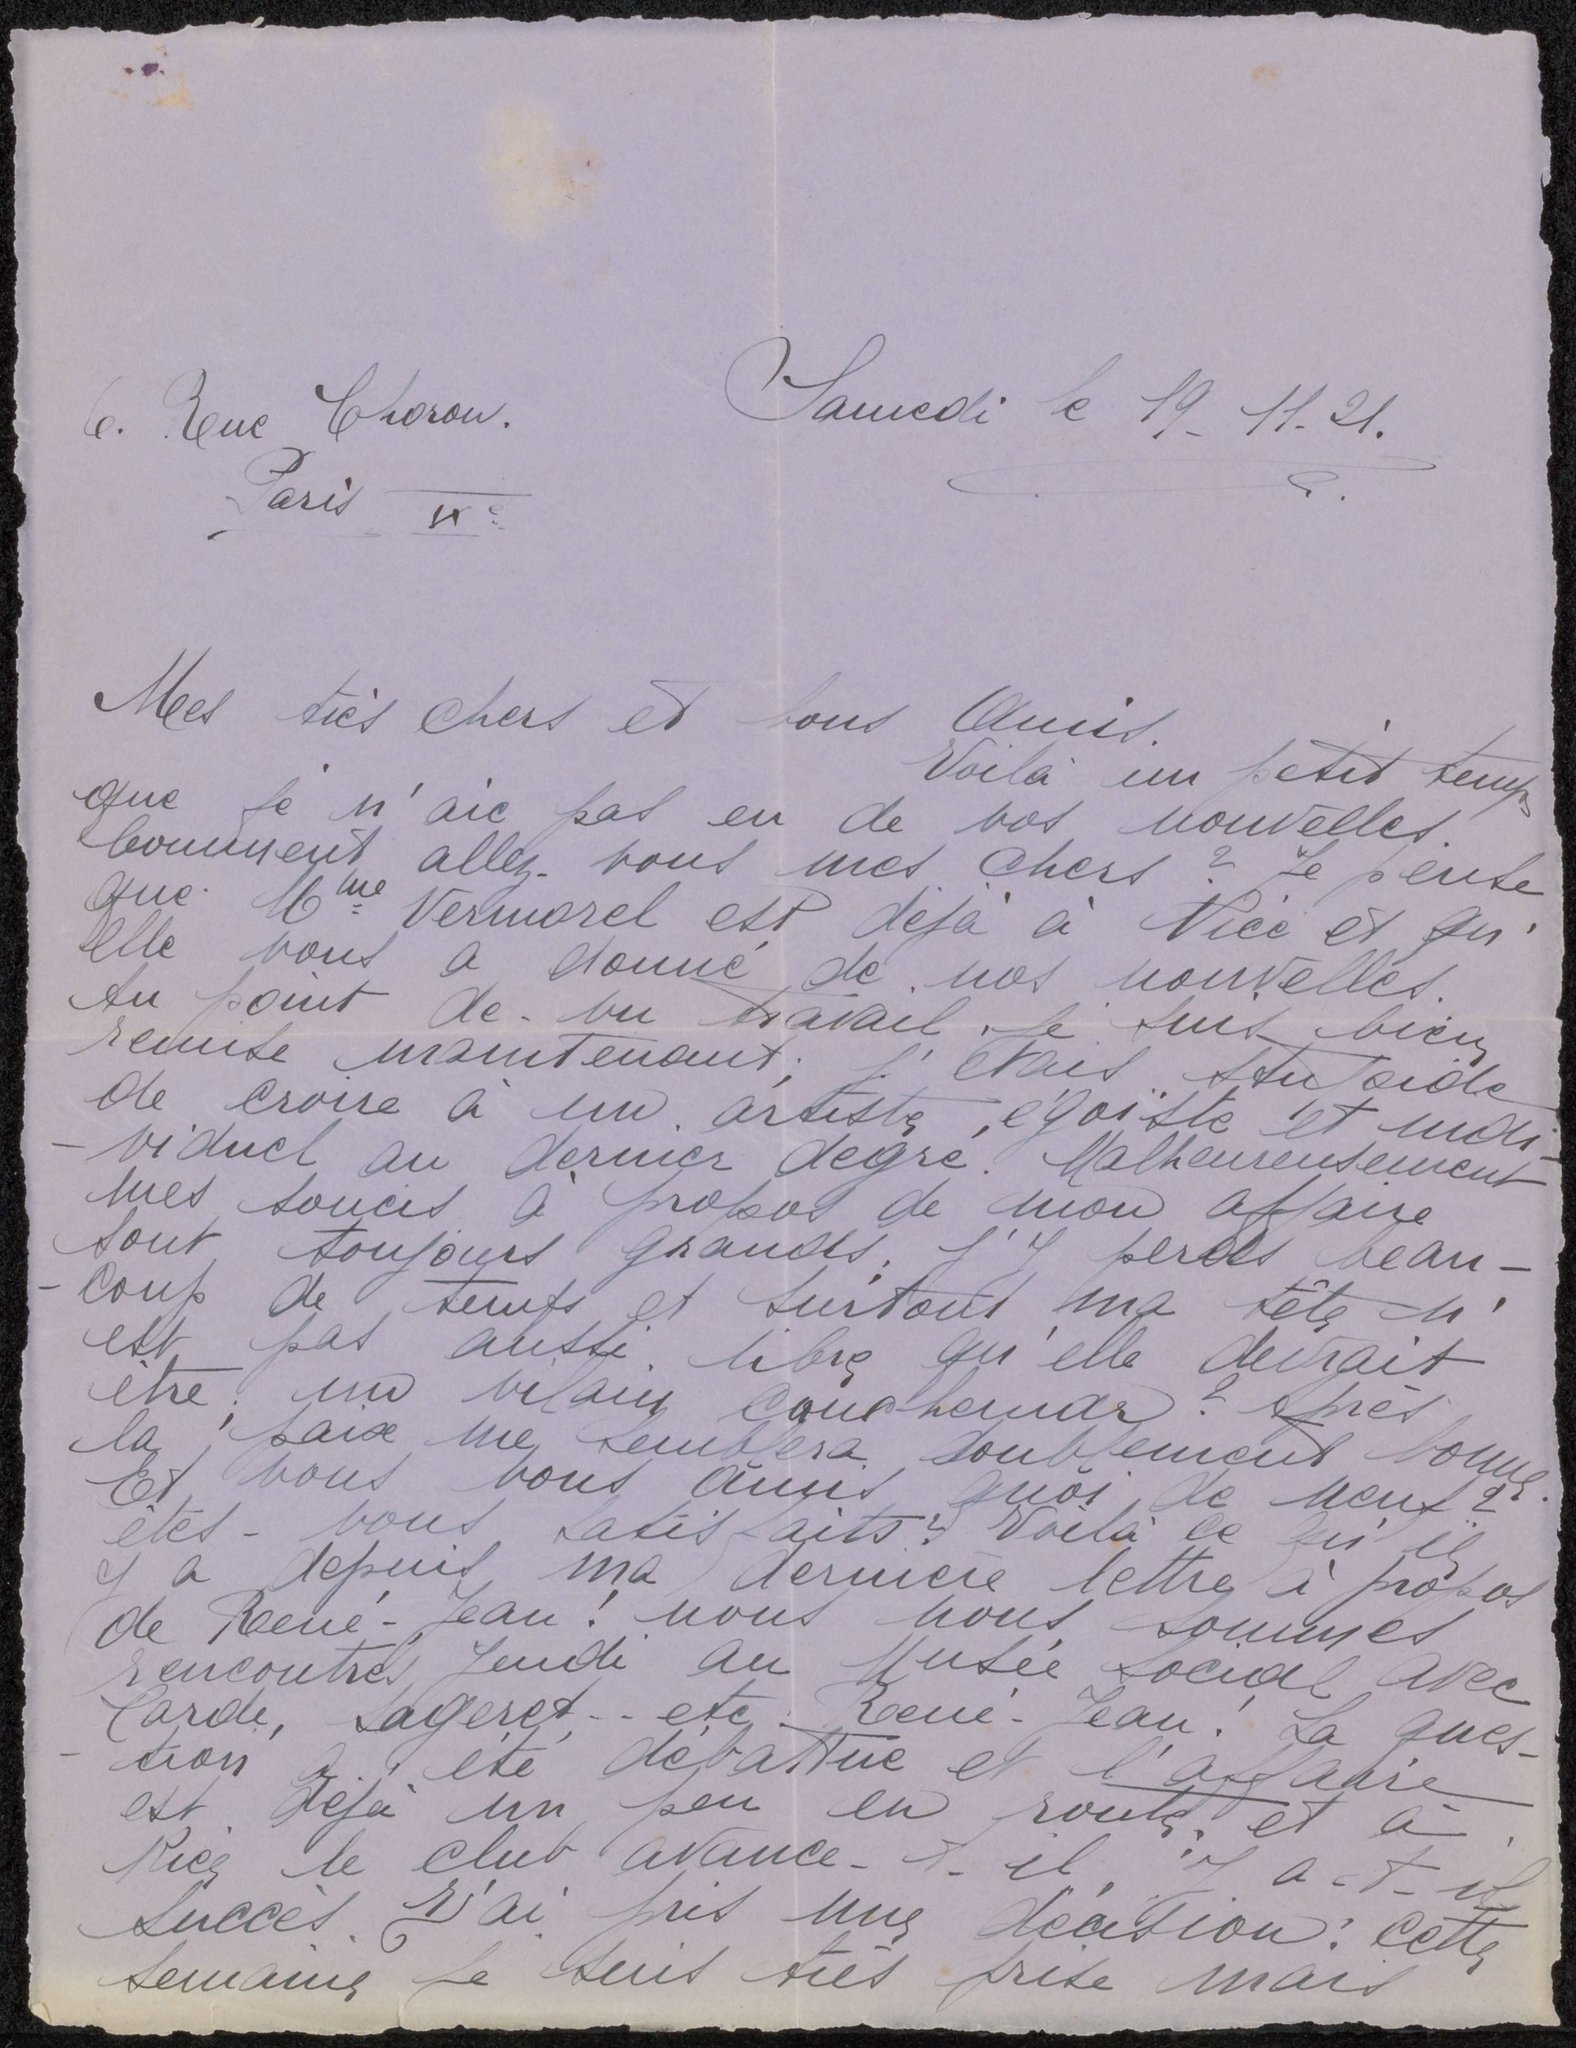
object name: letter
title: Brief aan Philip Zilcken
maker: rose imel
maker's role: draughtsman, painter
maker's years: 1901-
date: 1921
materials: ink, paper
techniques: pen, writing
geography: paris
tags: rené-jean, painter, draughtsman, philip zilcken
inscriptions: collector's mark: ‘RPK’